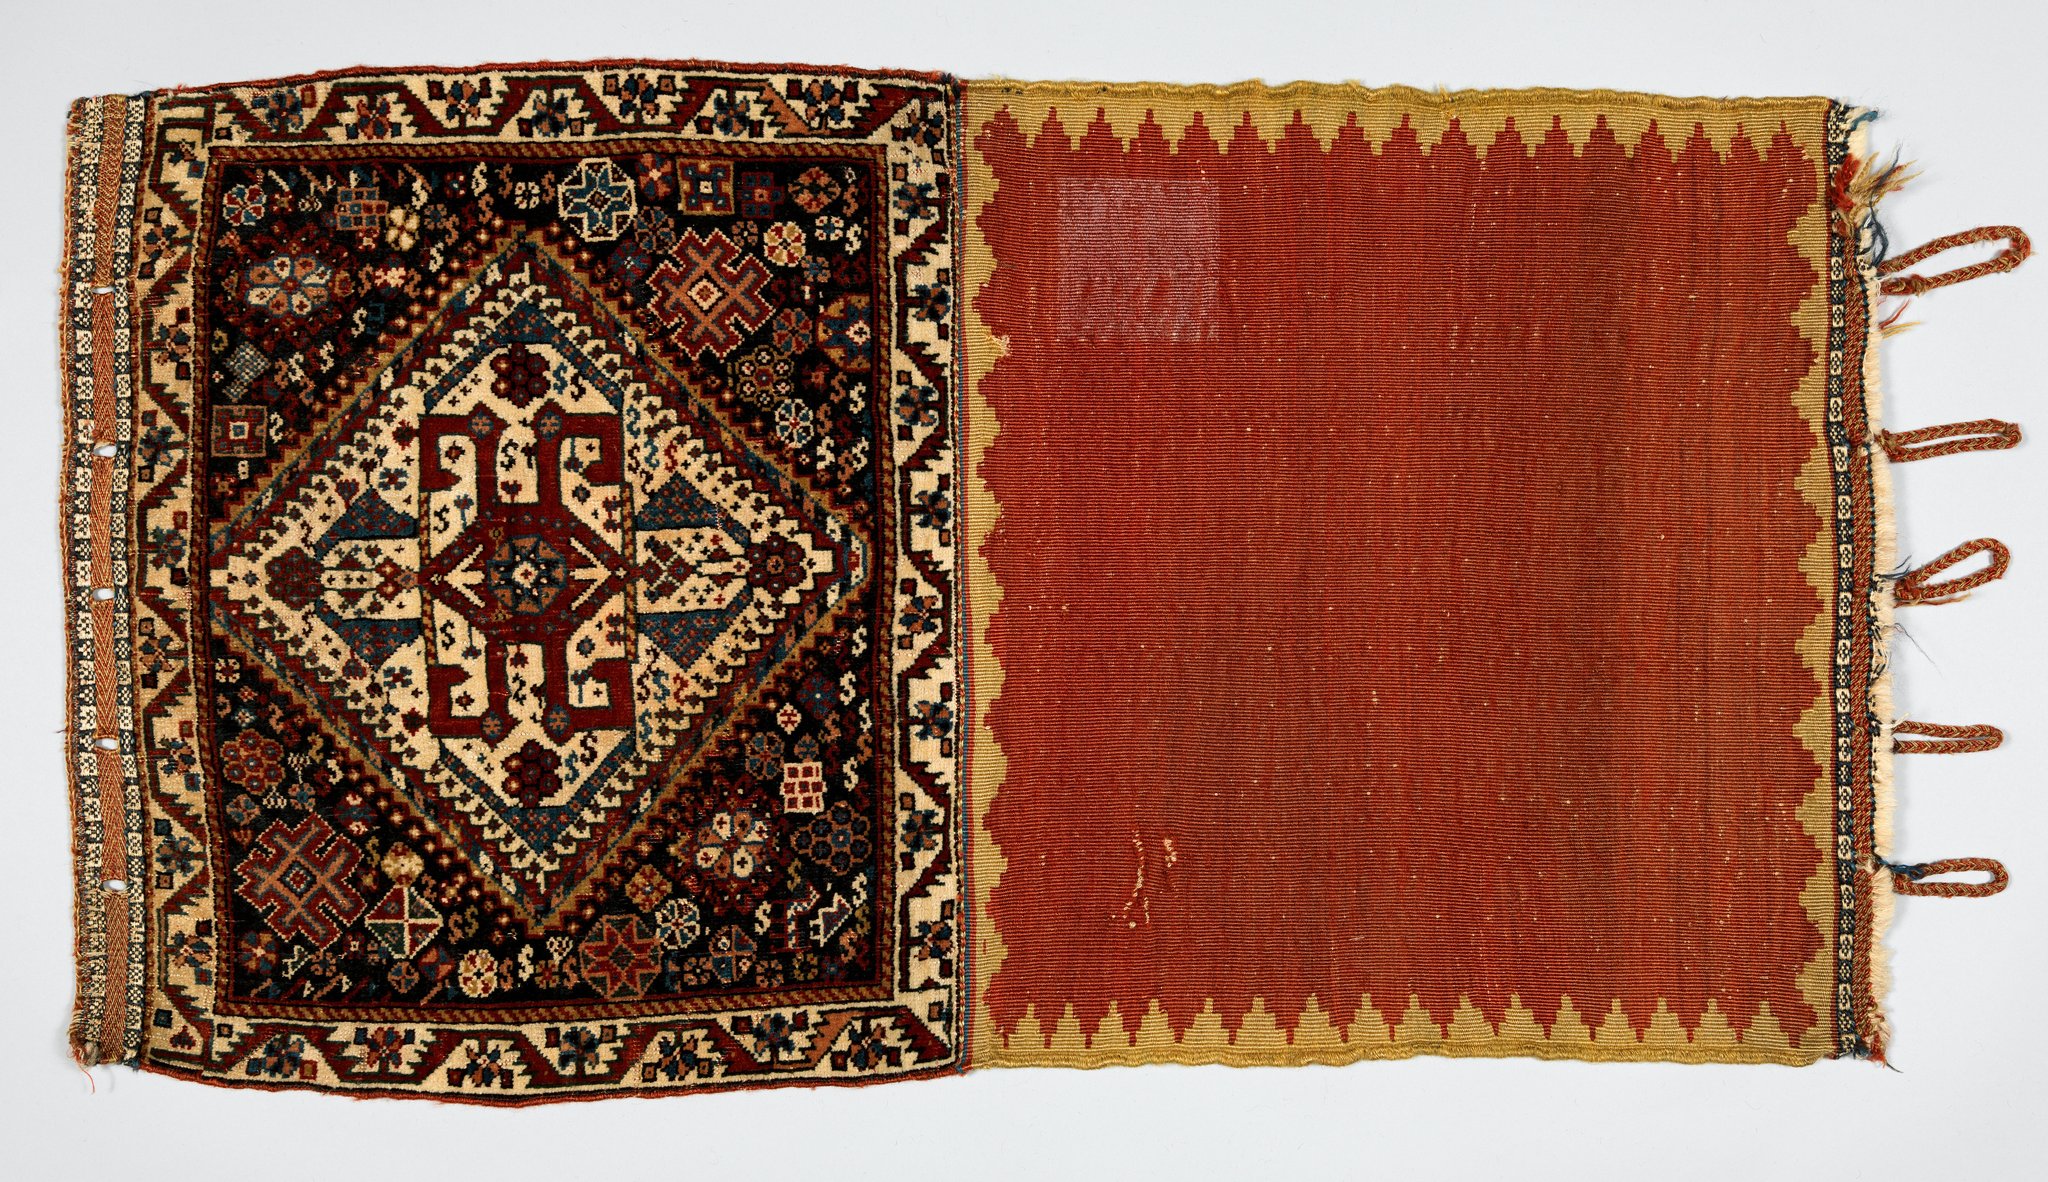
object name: saddle bag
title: Half a Double Saddle Bag (Khorjin)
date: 1875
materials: wool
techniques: asymmetrically knotted pile, slit, tapestry, weave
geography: iran